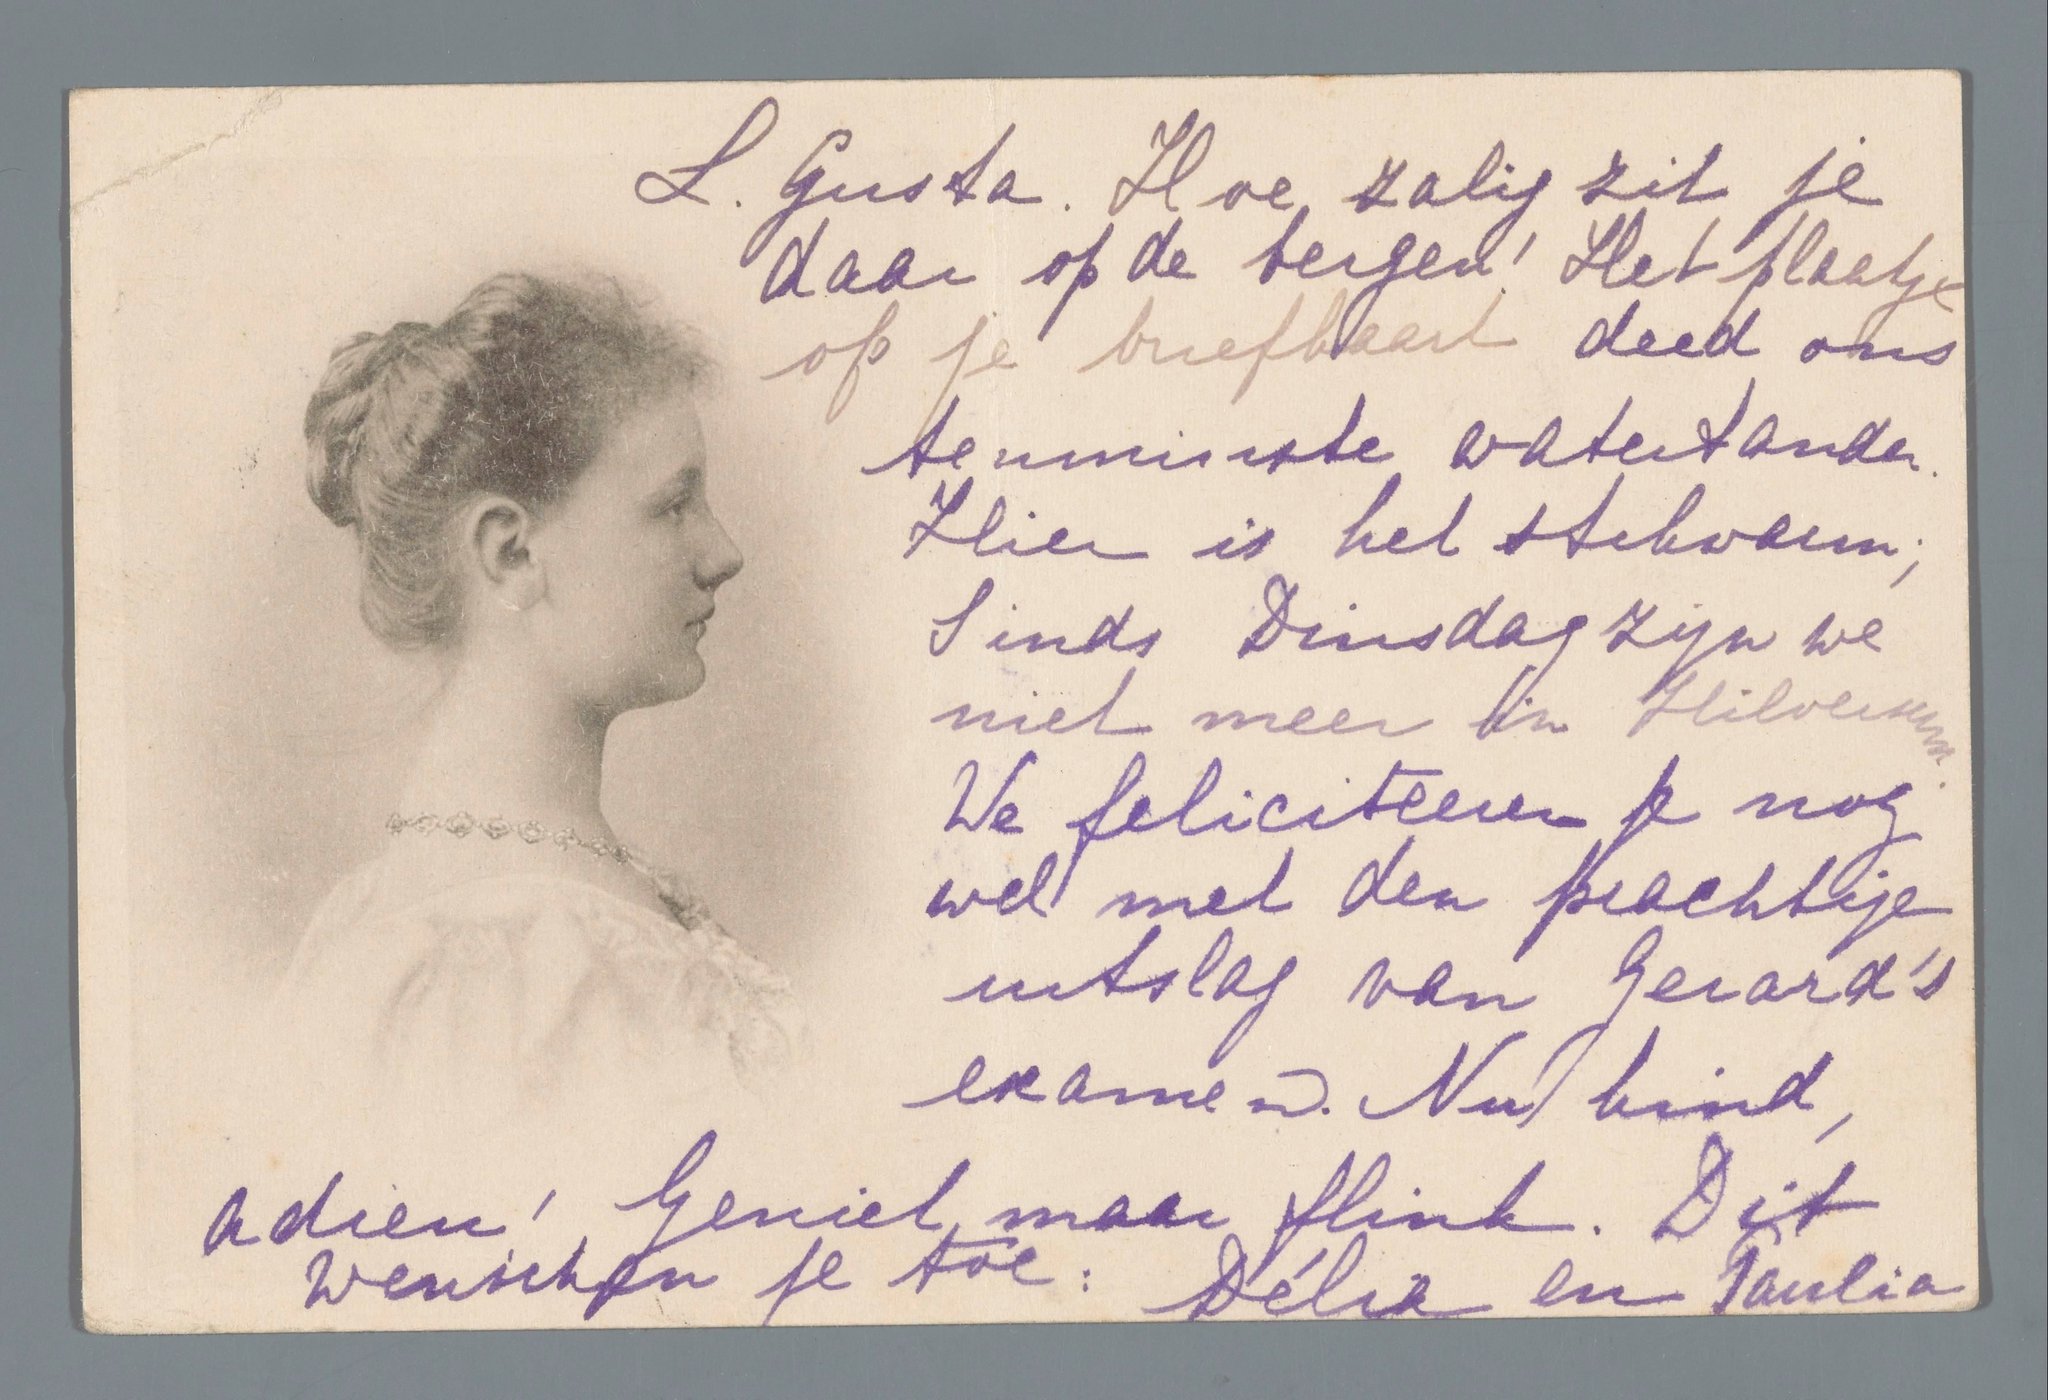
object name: photomechanical print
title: Portret van prinses Wilhelmina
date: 1897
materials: cardboard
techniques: photograph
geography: the hague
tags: the hague, print maker, wilhelmina of the netherlands, crown princess, historical persons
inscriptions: postage stamp